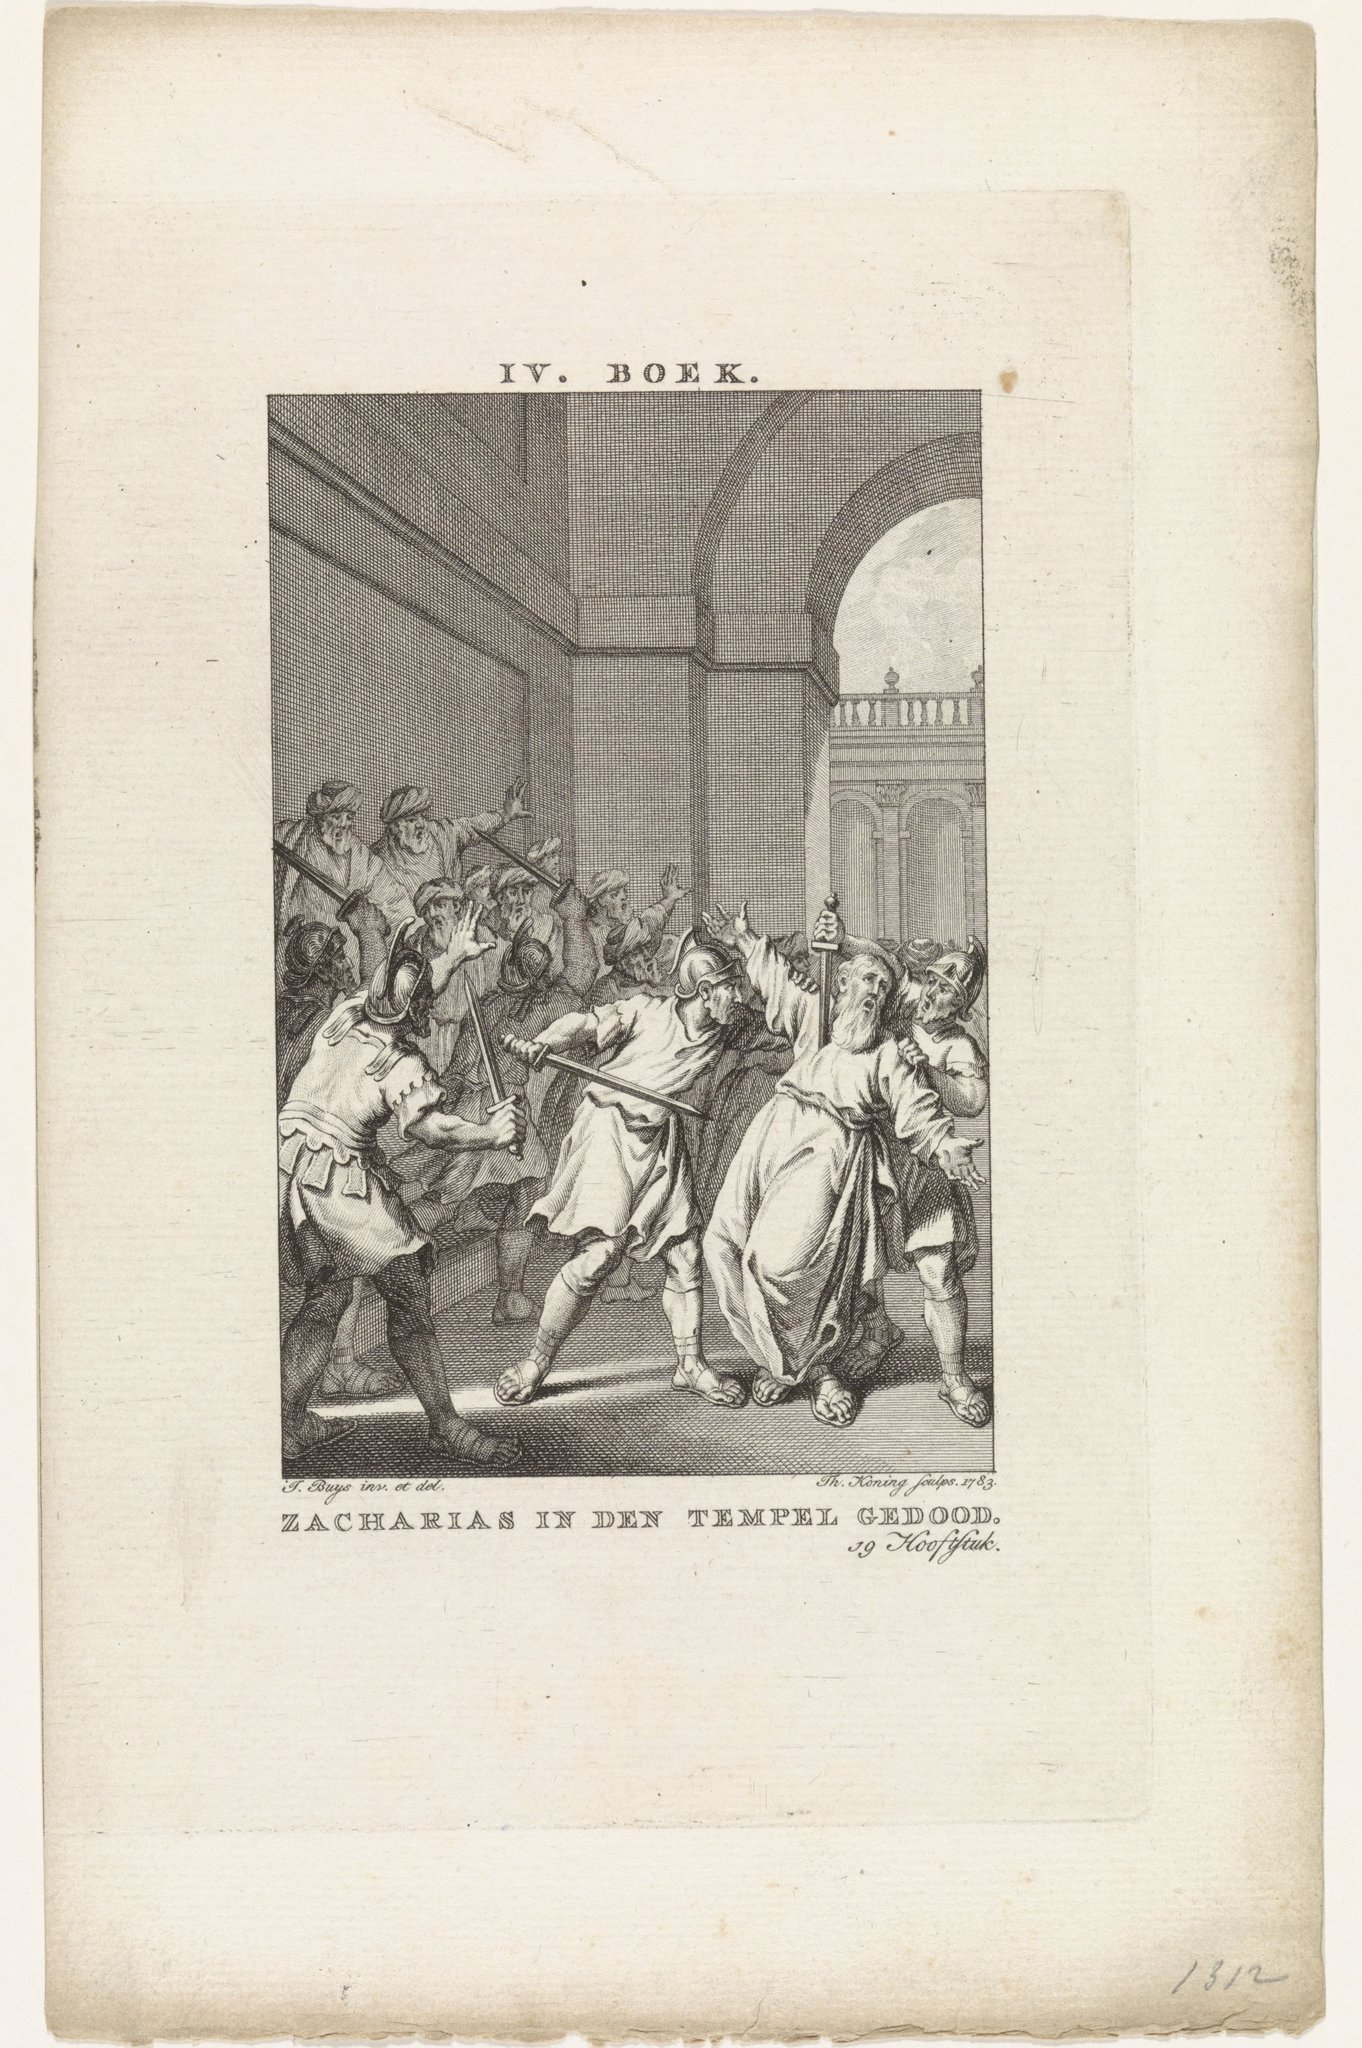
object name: print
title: Zacharias in den Tempel gedood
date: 1783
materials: paper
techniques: engraving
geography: amsterdam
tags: the murder of zacharias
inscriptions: collector's mark: Lugt 2228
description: De hogepriester Zacharias van Jeruzalem wordt in de tempel vermoord door een groep soldaten. Terwijl een van de soldaten een zwaard door het hart van Zacharias steekt heft de hogepriester zijn handen ten hemel. Deze prent is een illustratie bij het negentiende hoofdstuk van het vierde boek van 'Alle de werken van Flavius Josephus'.